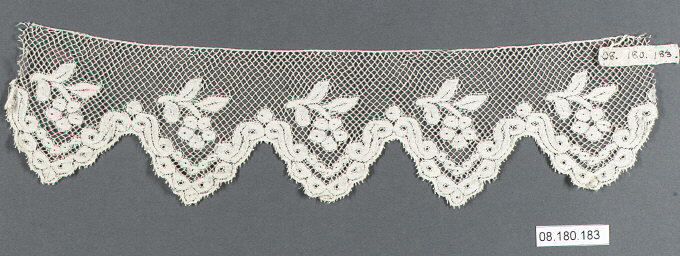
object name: fragment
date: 1801-1900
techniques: lace